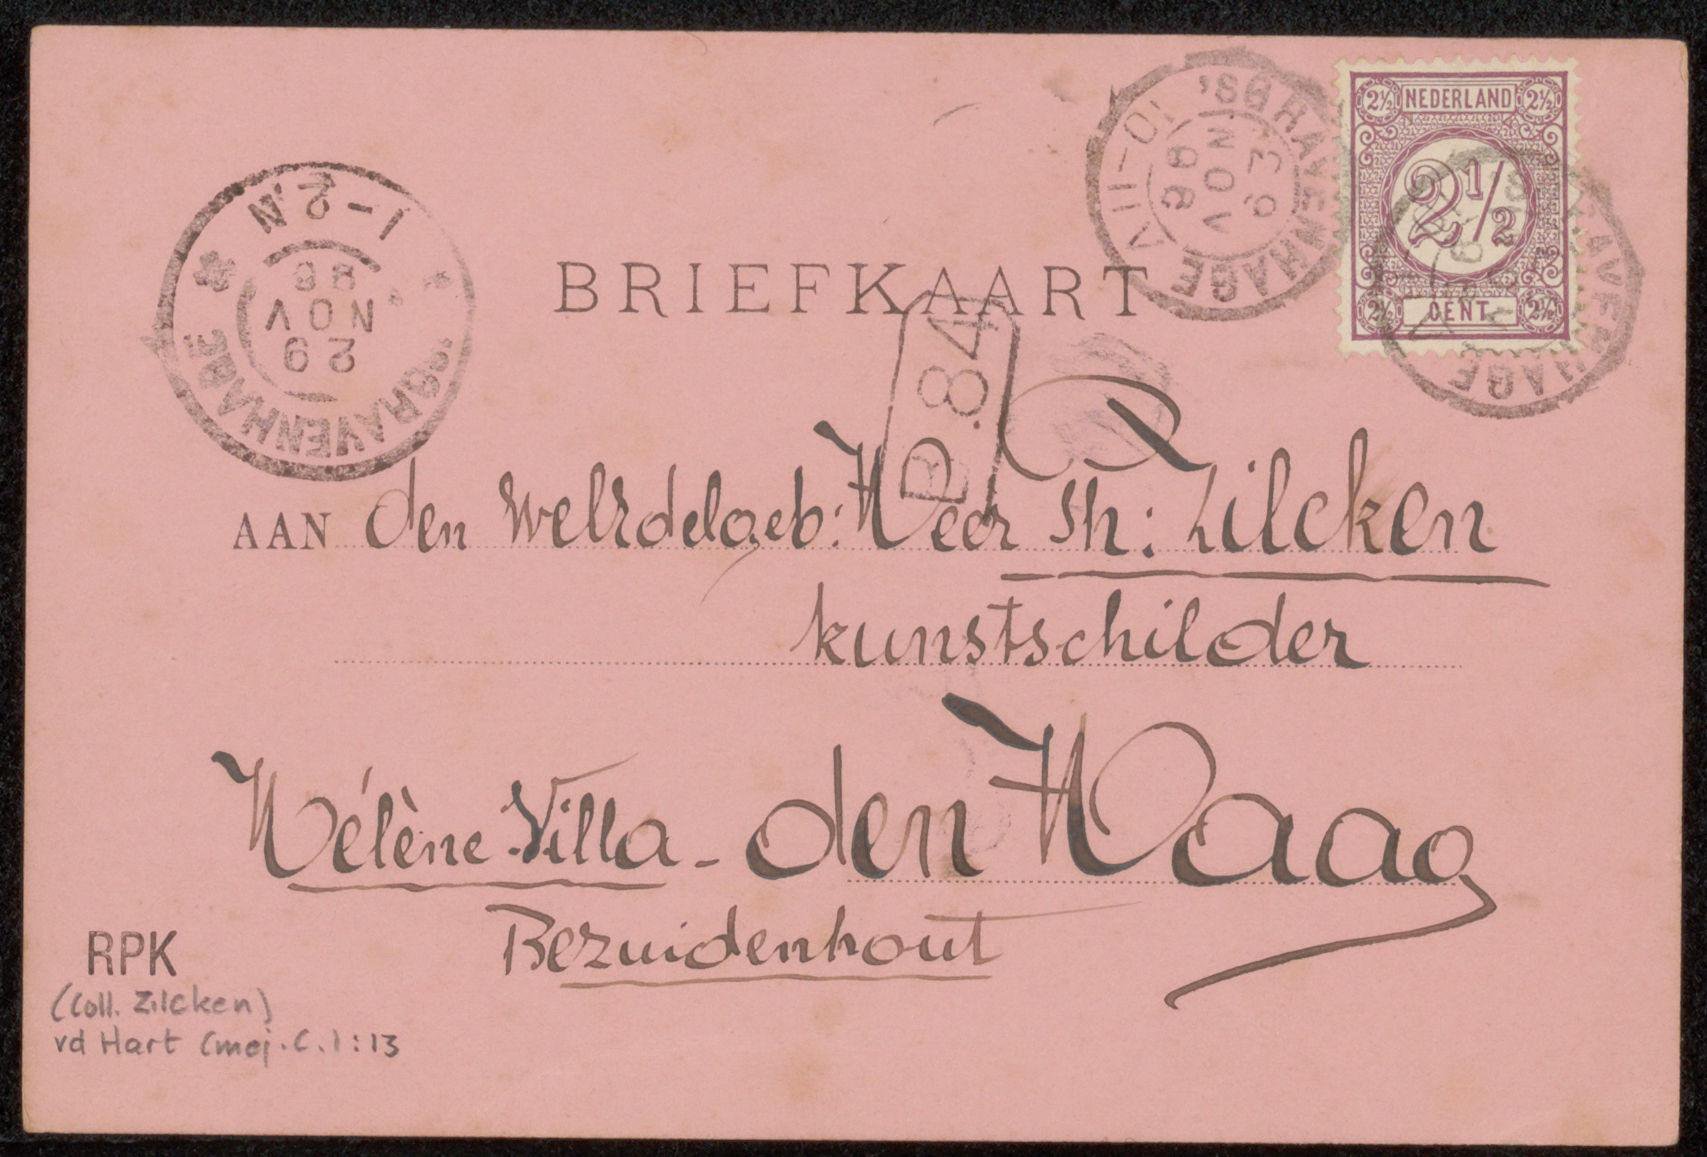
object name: postcard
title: Briefkaart aan Philip Zilcken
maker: cornelia van der hart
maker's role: print maker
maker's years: 1851-1940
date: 1896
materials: cardboard, ink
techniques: pen, writing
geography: the hague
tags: the hague, painter, draughtsman, philip zilcken, drawing, diseases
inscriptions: collector's mark: ‘RPK’